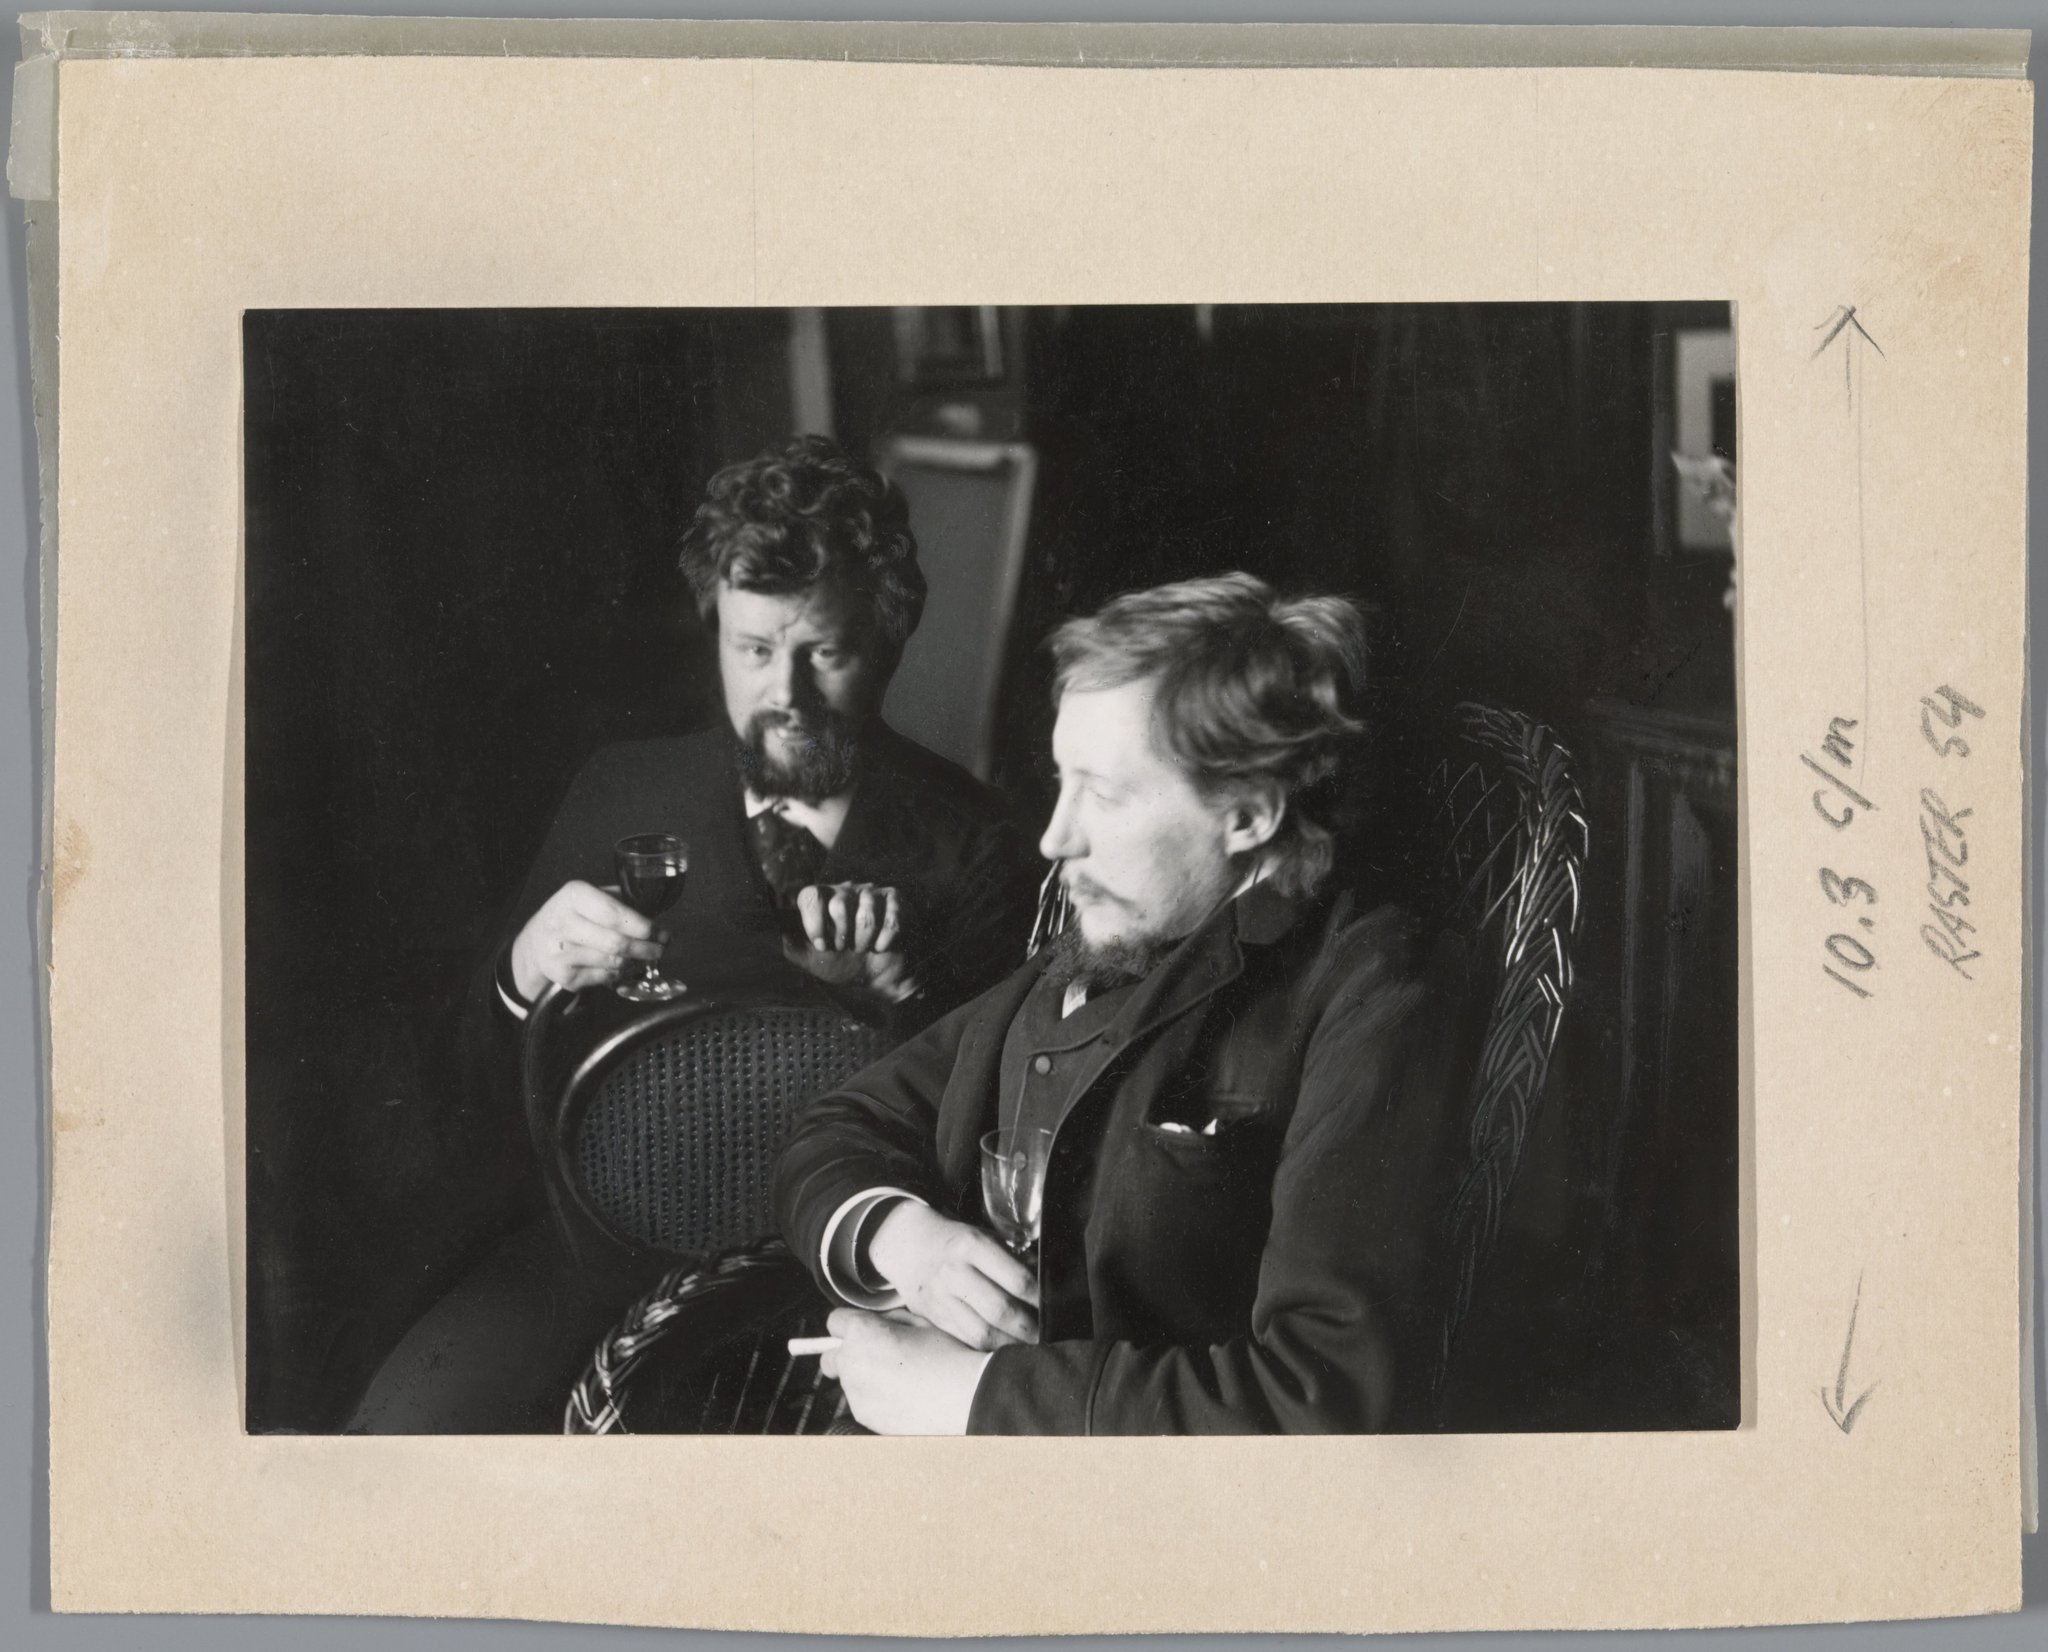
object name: photograph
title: Reproductie naar een foto, schilderij, tekening of prent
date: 1860-1915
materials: cardboard, paper, photographic support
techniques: gelatin silver print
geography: netherlands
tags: the hague, willem kloos